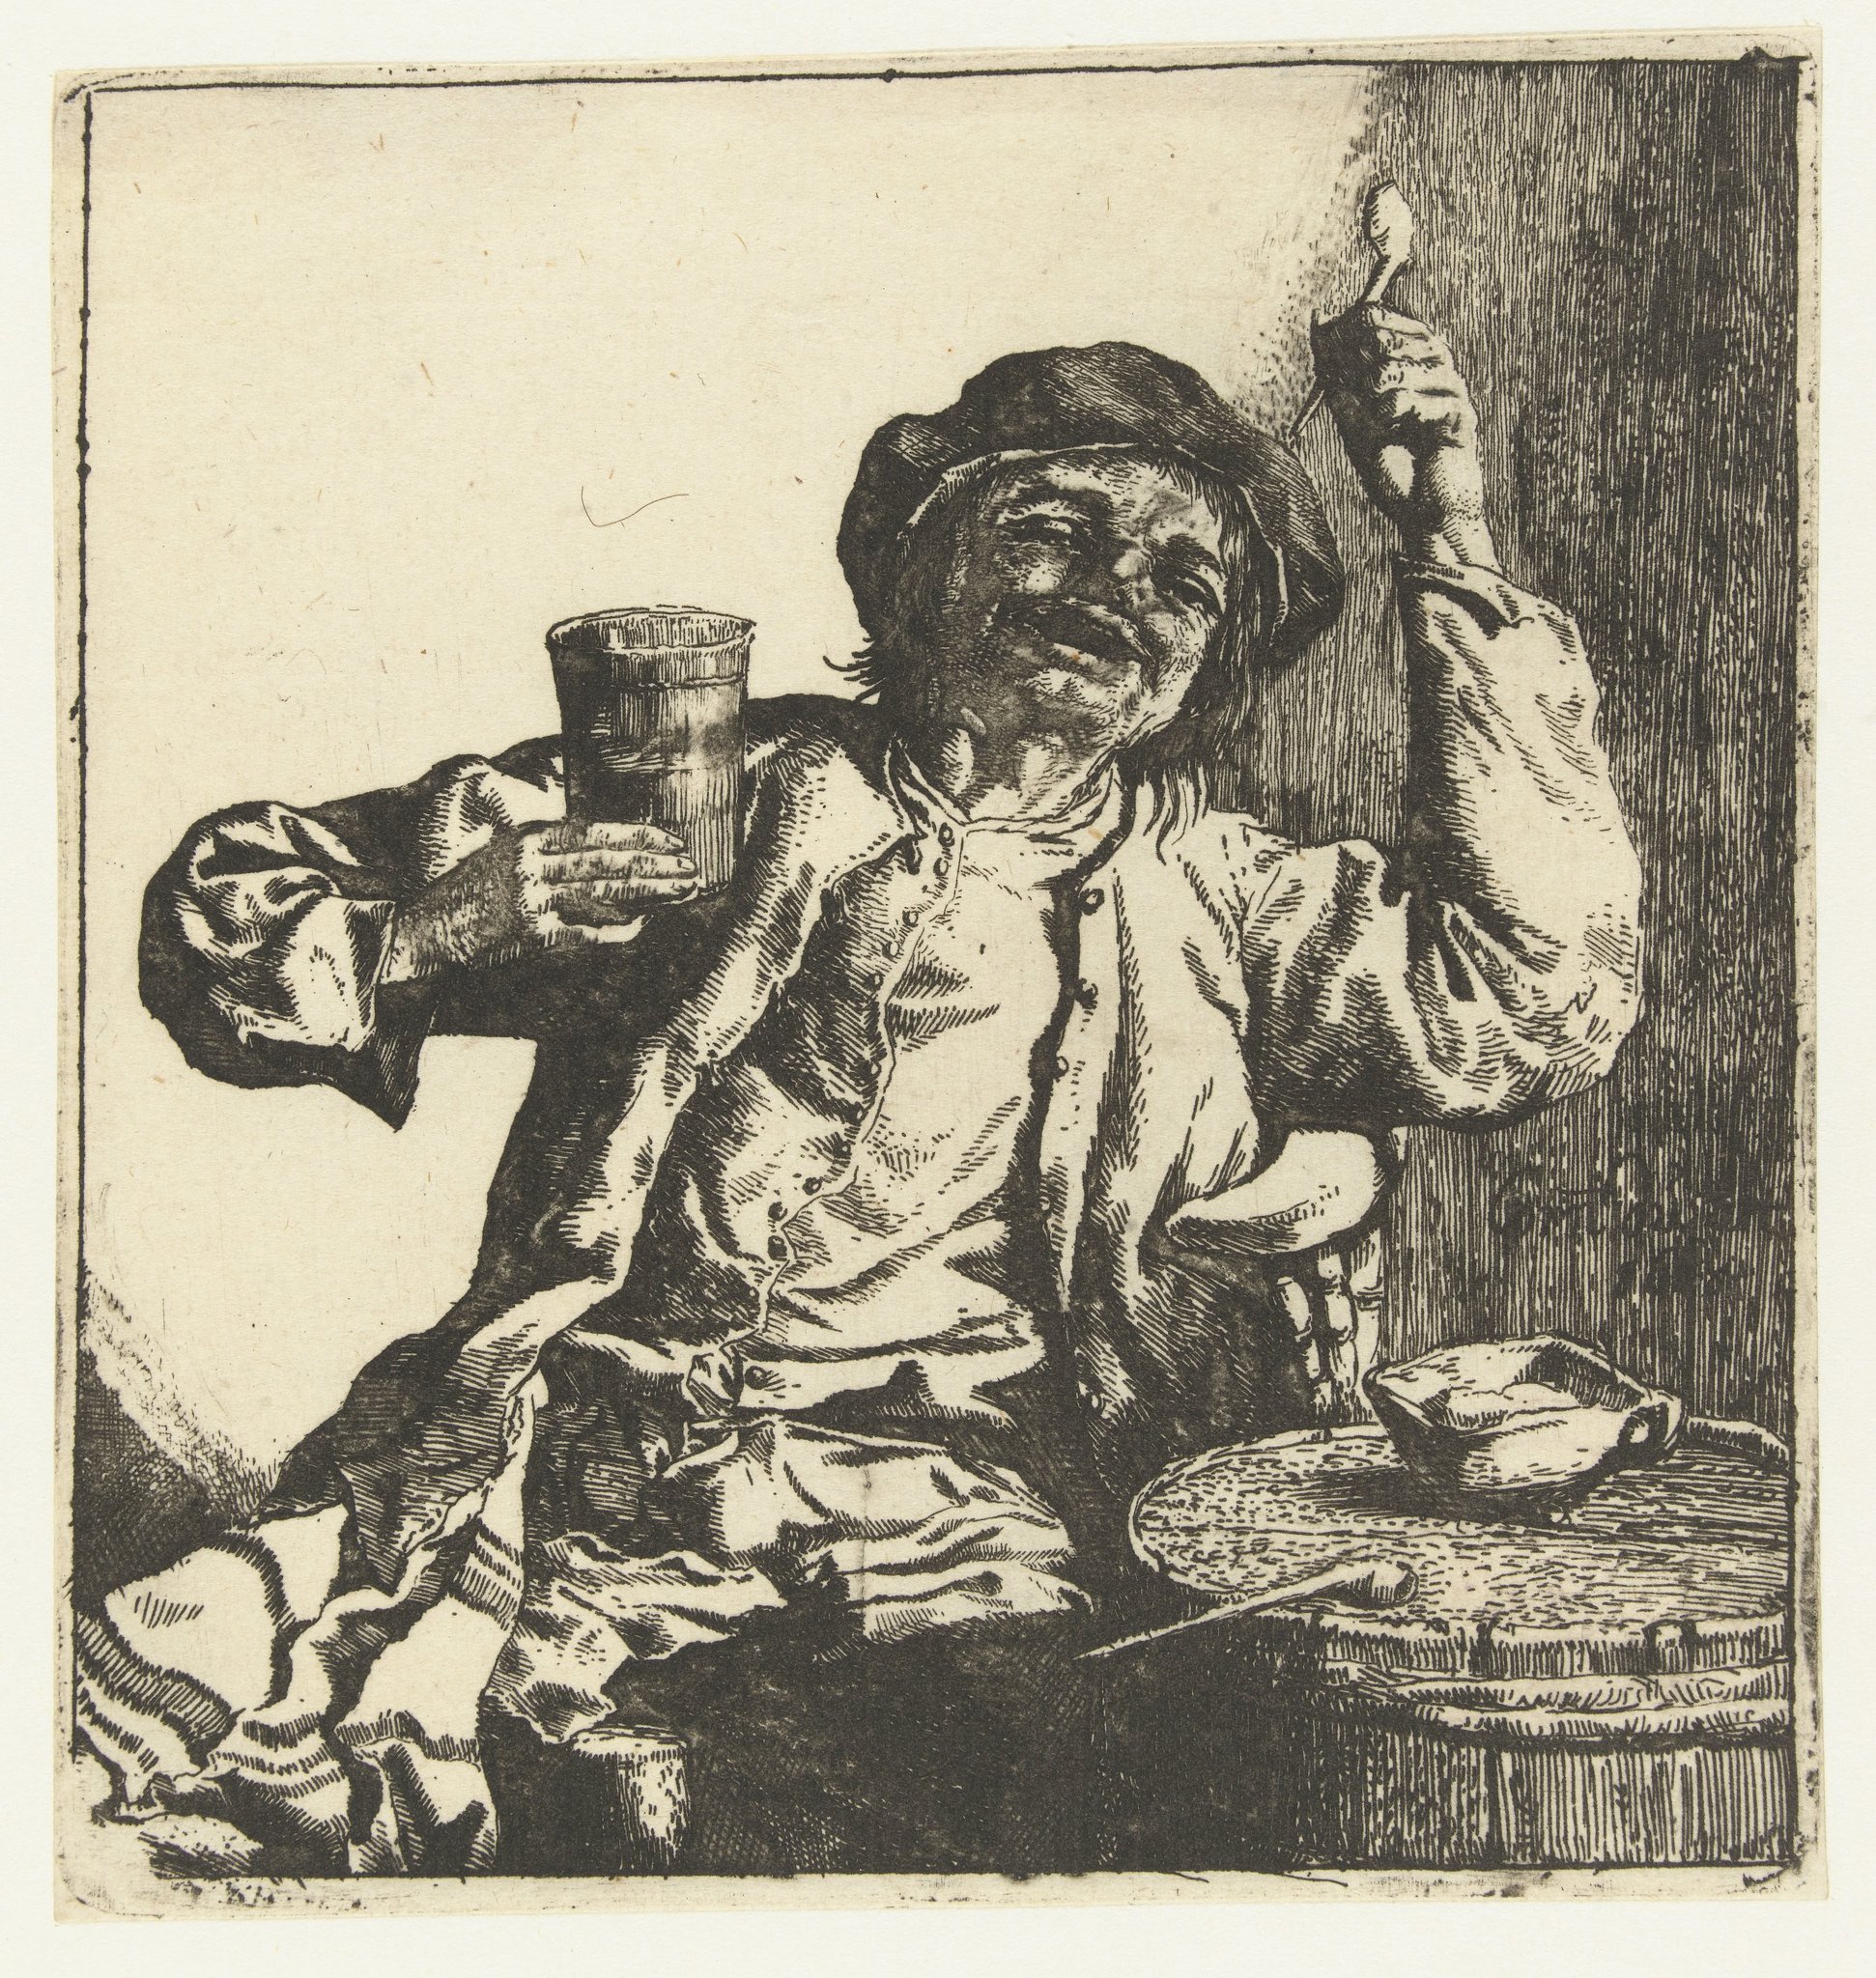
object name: print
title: Drinkende man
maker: cornelis dusart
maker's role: draughtsman, painter, print maker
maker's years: 1660-1704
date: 1685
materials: paper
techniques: etching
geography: haarlem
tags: vocal music, singing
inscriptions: collector's mark: Lugt 240